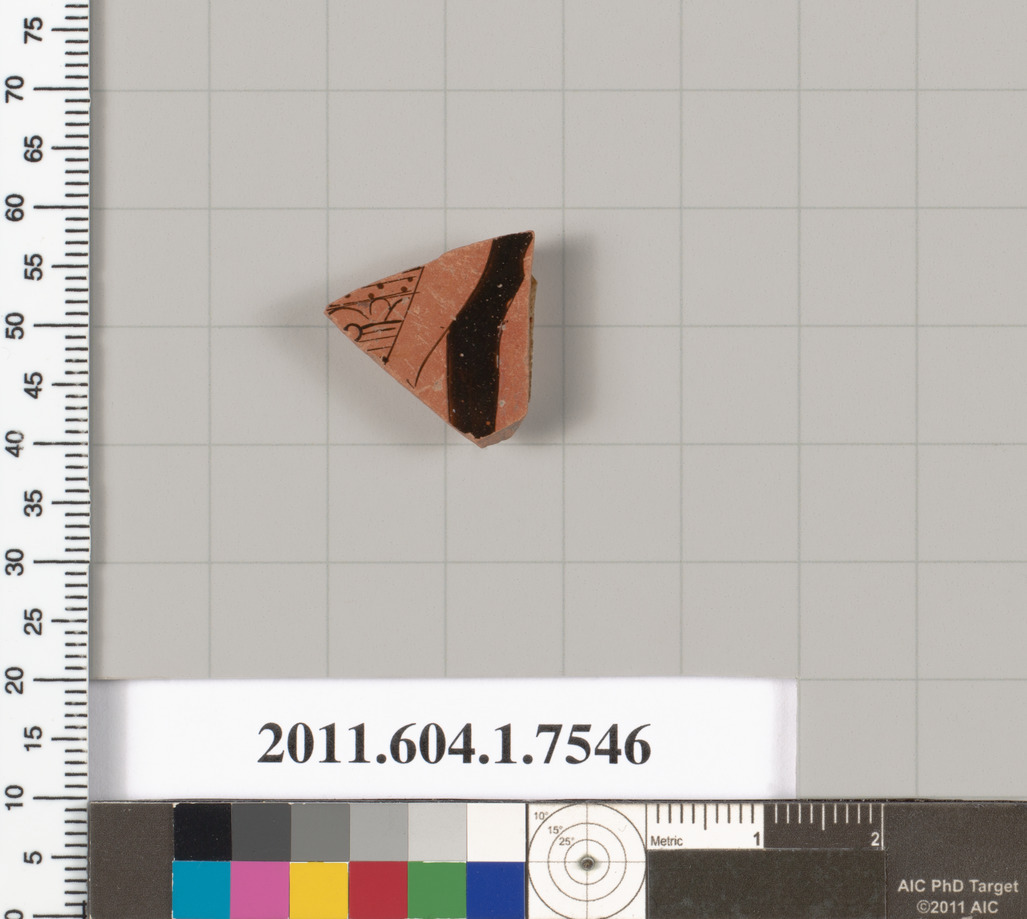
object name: kylix fragment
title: Terracotta fragment of a kylix (drinking cup)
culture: greek, attic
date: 460-450 BCE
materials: terracotta